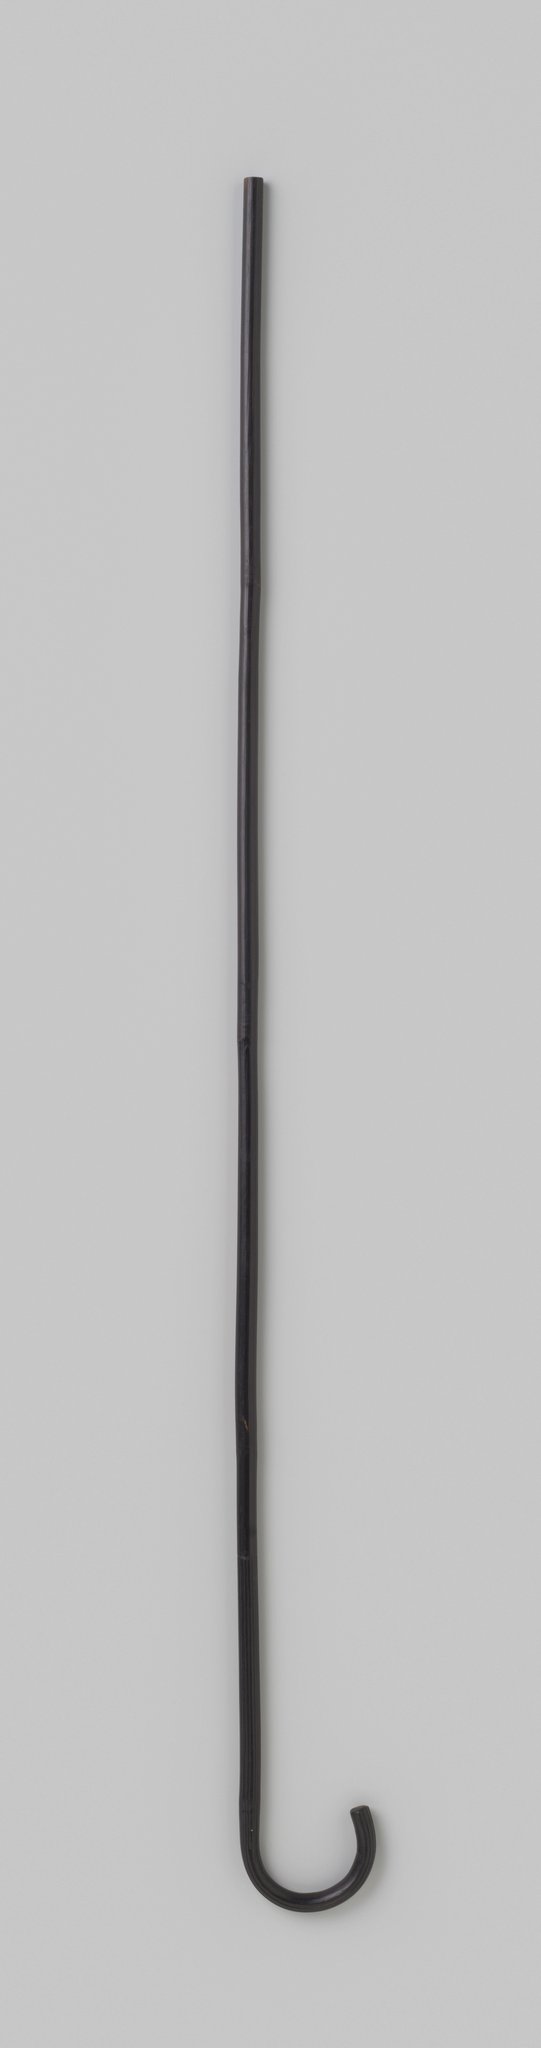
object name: stok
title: Onderstok van een paraplu of parasol van zwart geverfd hout met een gekromde haak, voorzien van cannelures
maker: gustav schnitzler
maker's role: paraplufabrikant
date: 1920-1940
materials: wood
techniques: cutting, painting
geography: nijmegen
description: Onderstok van een parapluie of parasol van zwart geverfd hout met een gekromde haak, voorzien van cannelures.